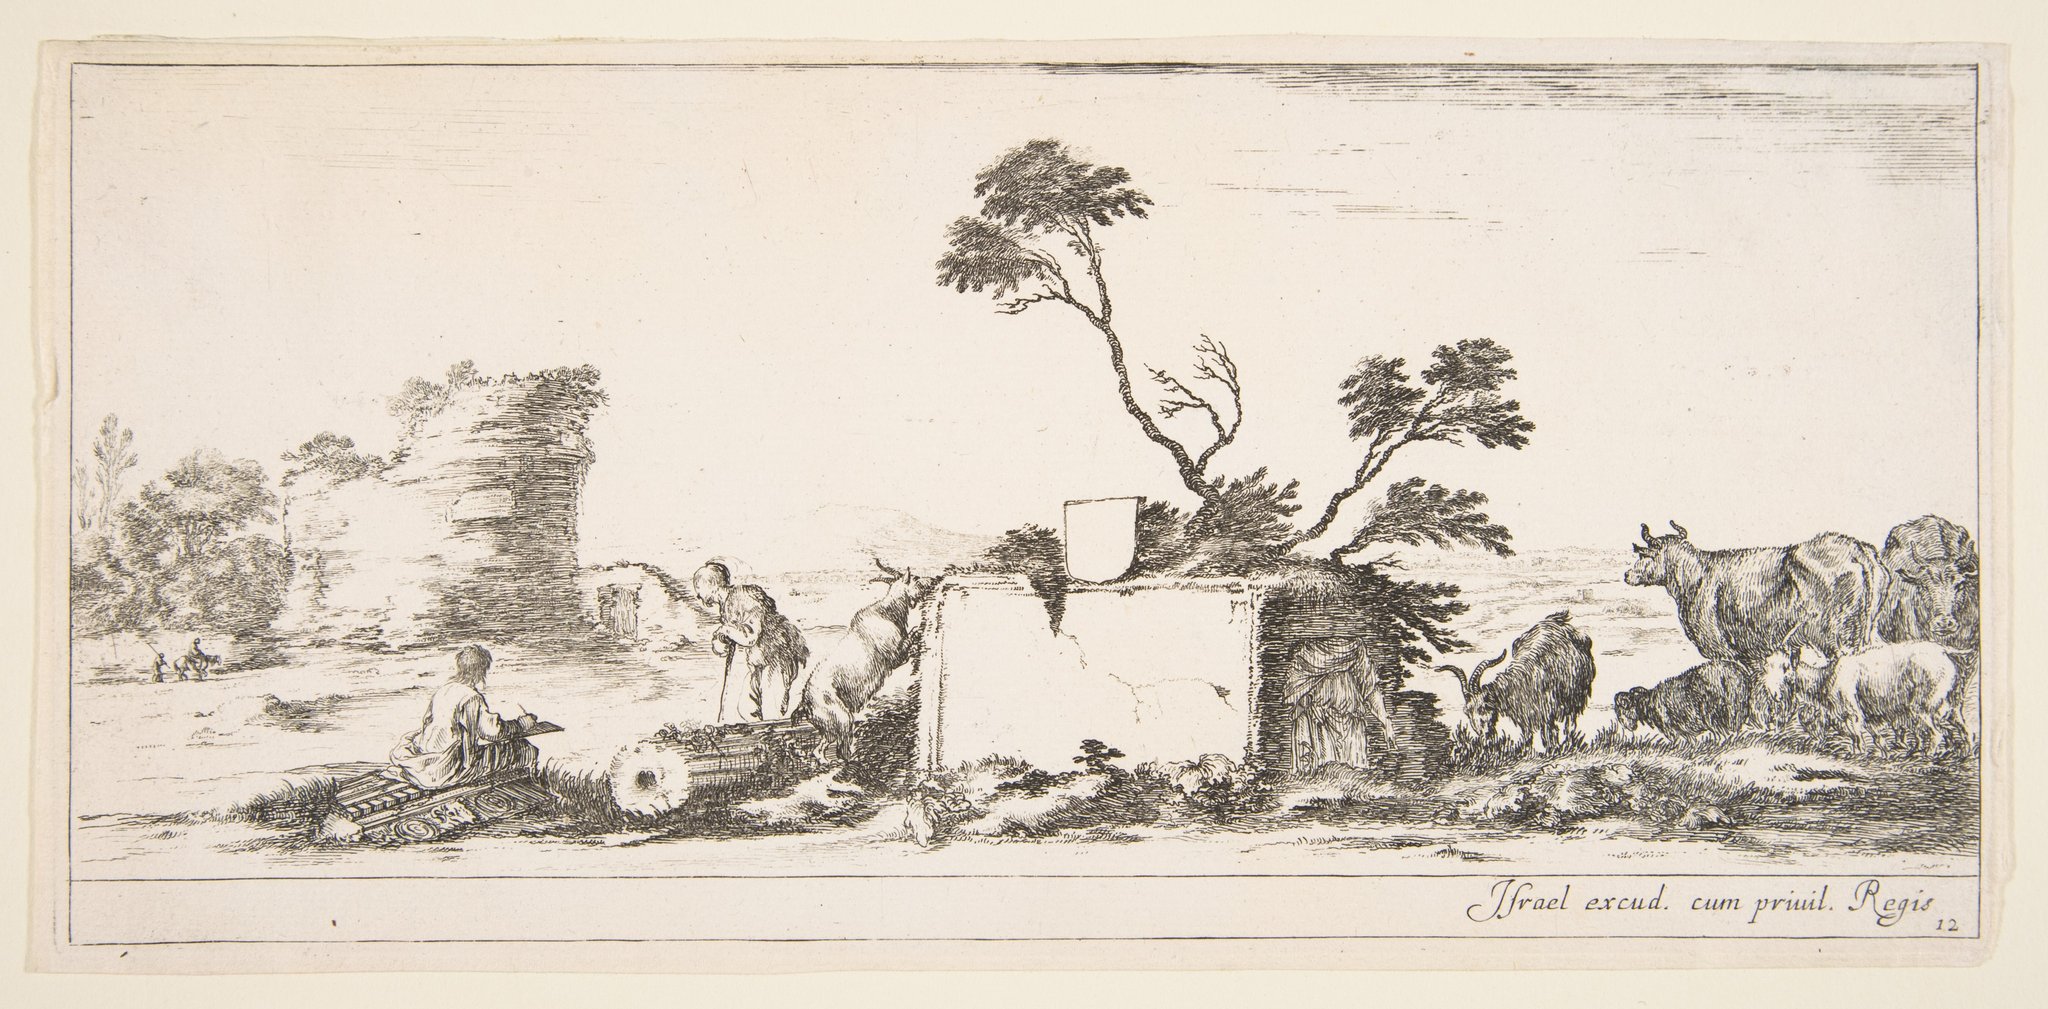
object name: print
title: Plate 12: a seated draughtsman to left, a standing shepherd next to him to right, ruins and animals to the right, a tower in ruins to left in the background, from 'Various landscapes' (Divers paysages)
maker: stefano della bella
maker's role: artist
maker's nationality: italian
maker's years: 1610-1664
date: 1641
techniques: etching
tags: animals,ruins,men,shepherds